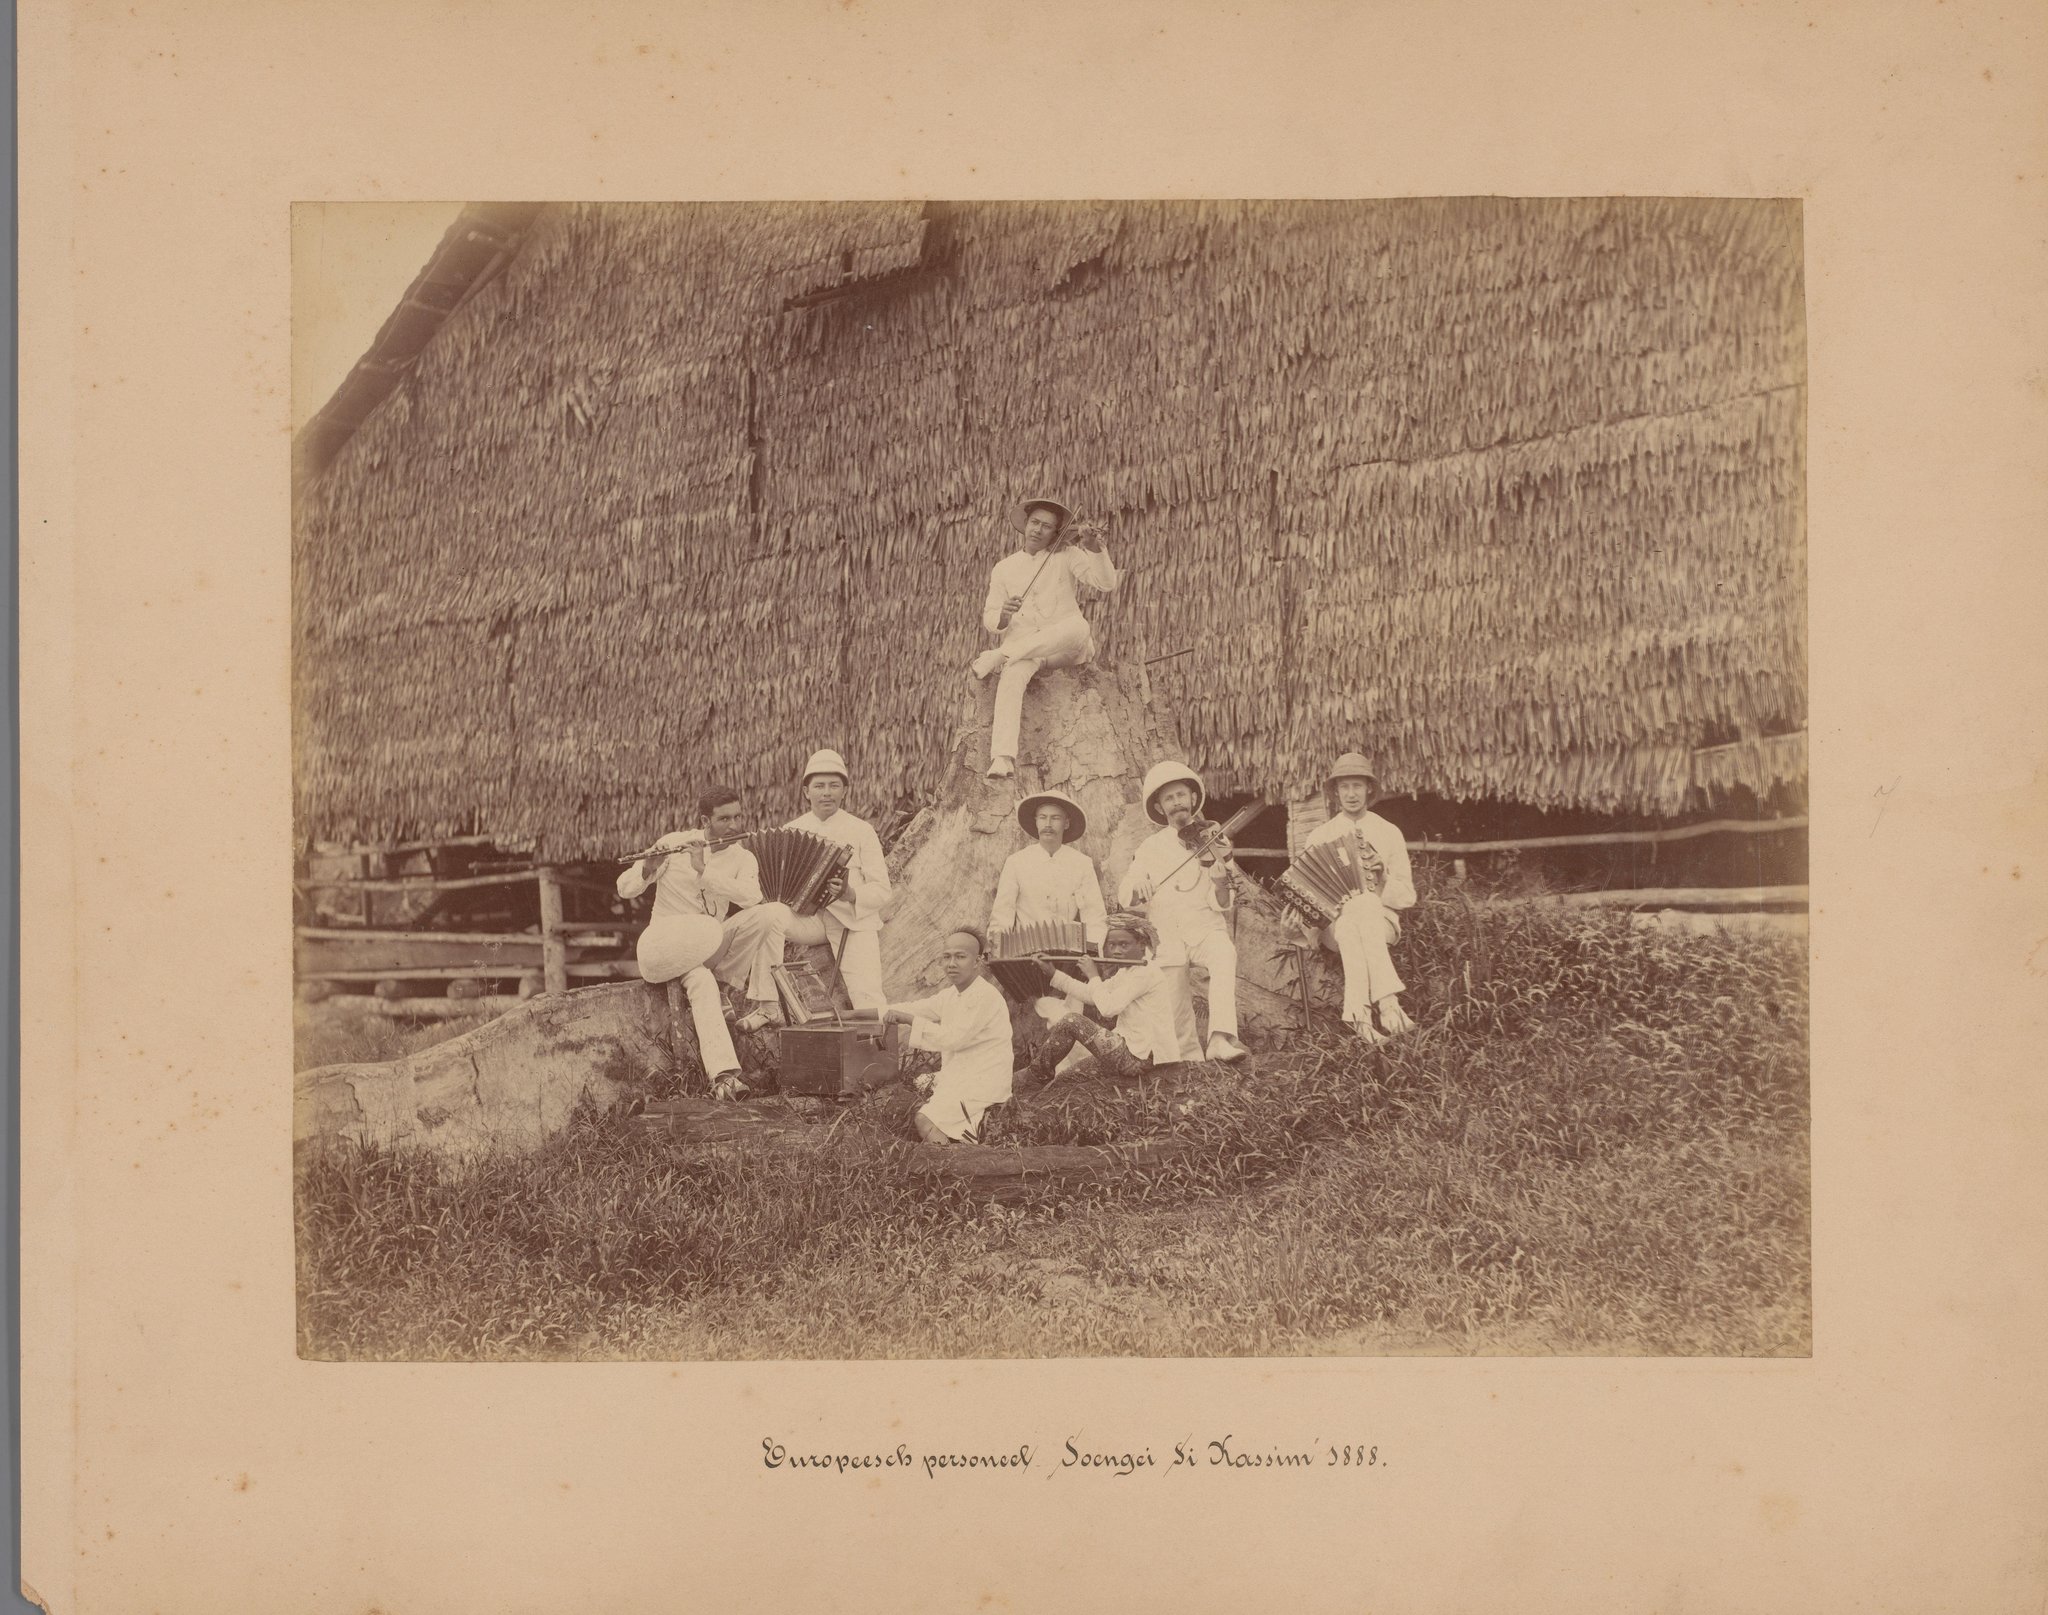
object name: album leaf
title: "Europees personeel, Soengei [sic] Si Kassim", Nederlands-Indië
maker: Anonymous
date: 1888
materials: cardboard, photographic support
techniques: albumen print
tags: dutch east indies, the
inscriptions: inscription: ‘Europeesch personeel Soengei Si Kassim 1888.’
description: Groepsportret van zeven musicerende mannen van Indonesische en Europese origine, met accordeon, dwarsfluit, viool en een houten instrument in de vorm van een kastje met een draaihendel op de voorgrond.